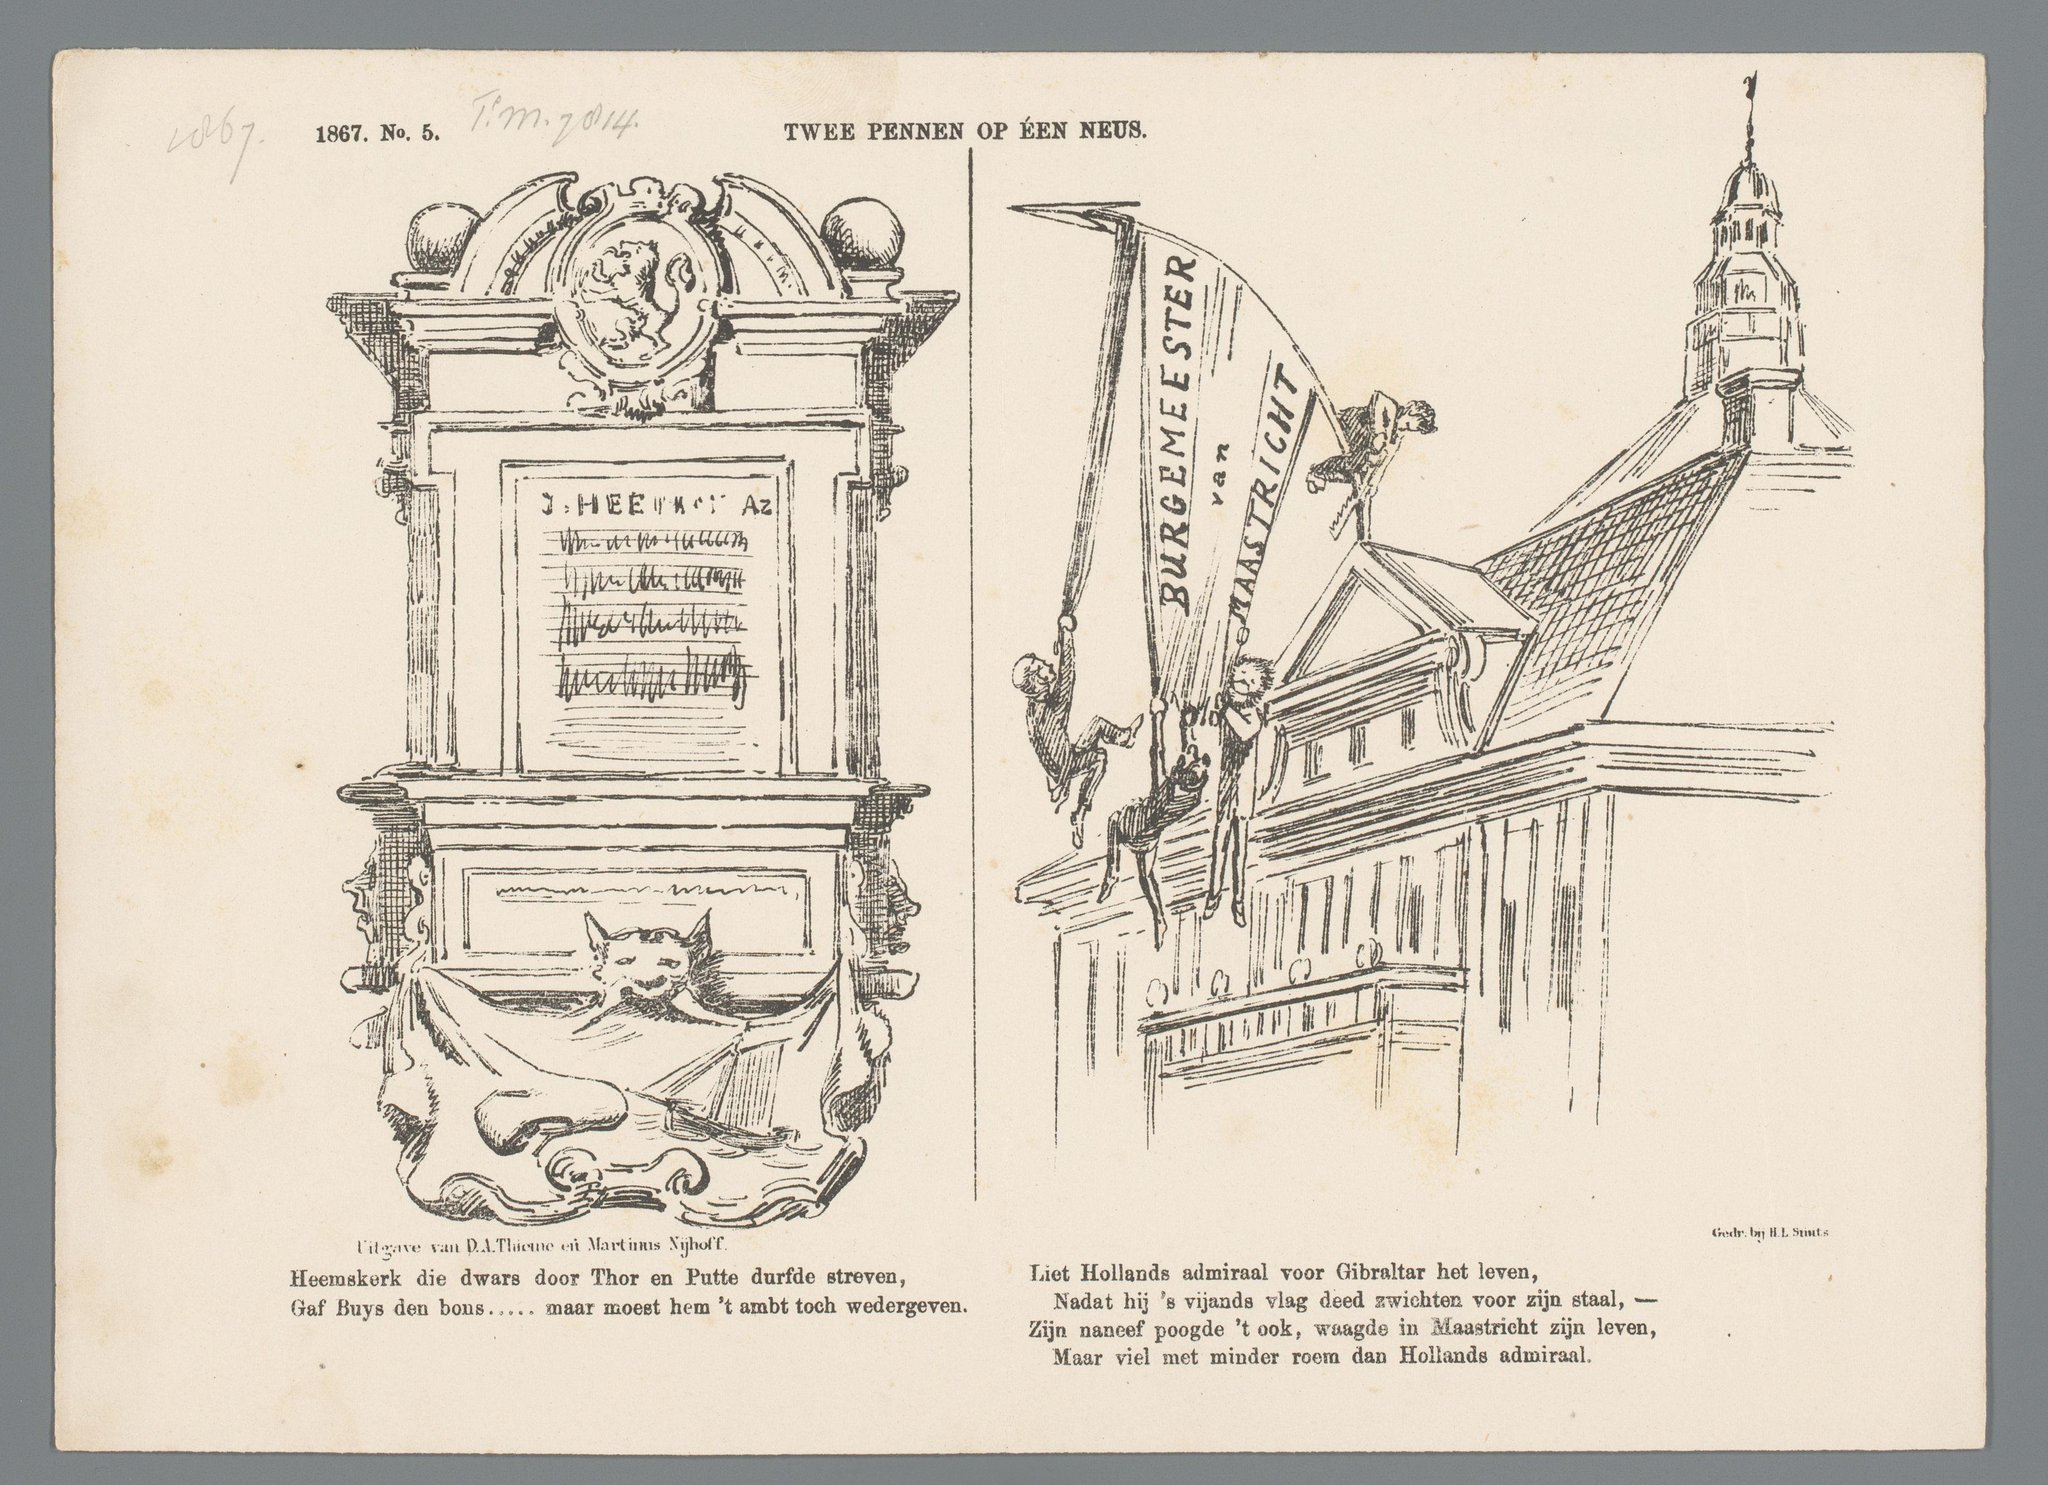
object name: cartoon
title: Spotprent op twee benoemingen, 1867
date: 1867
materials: paper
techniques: lithograph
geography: netherlands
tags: amsterdam, jacob van heemskerck, maastricht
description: Spotprent op de benoeming van J.T. Buijs als secretaris van het Collegie van Visscherijen en op de herverkiezing van burgemeester Pijls in Maastricht, 1867. Plaat verschenen bij het weekblad De Nederlandsche Spectator, nr. 5, 2 februari 1867.